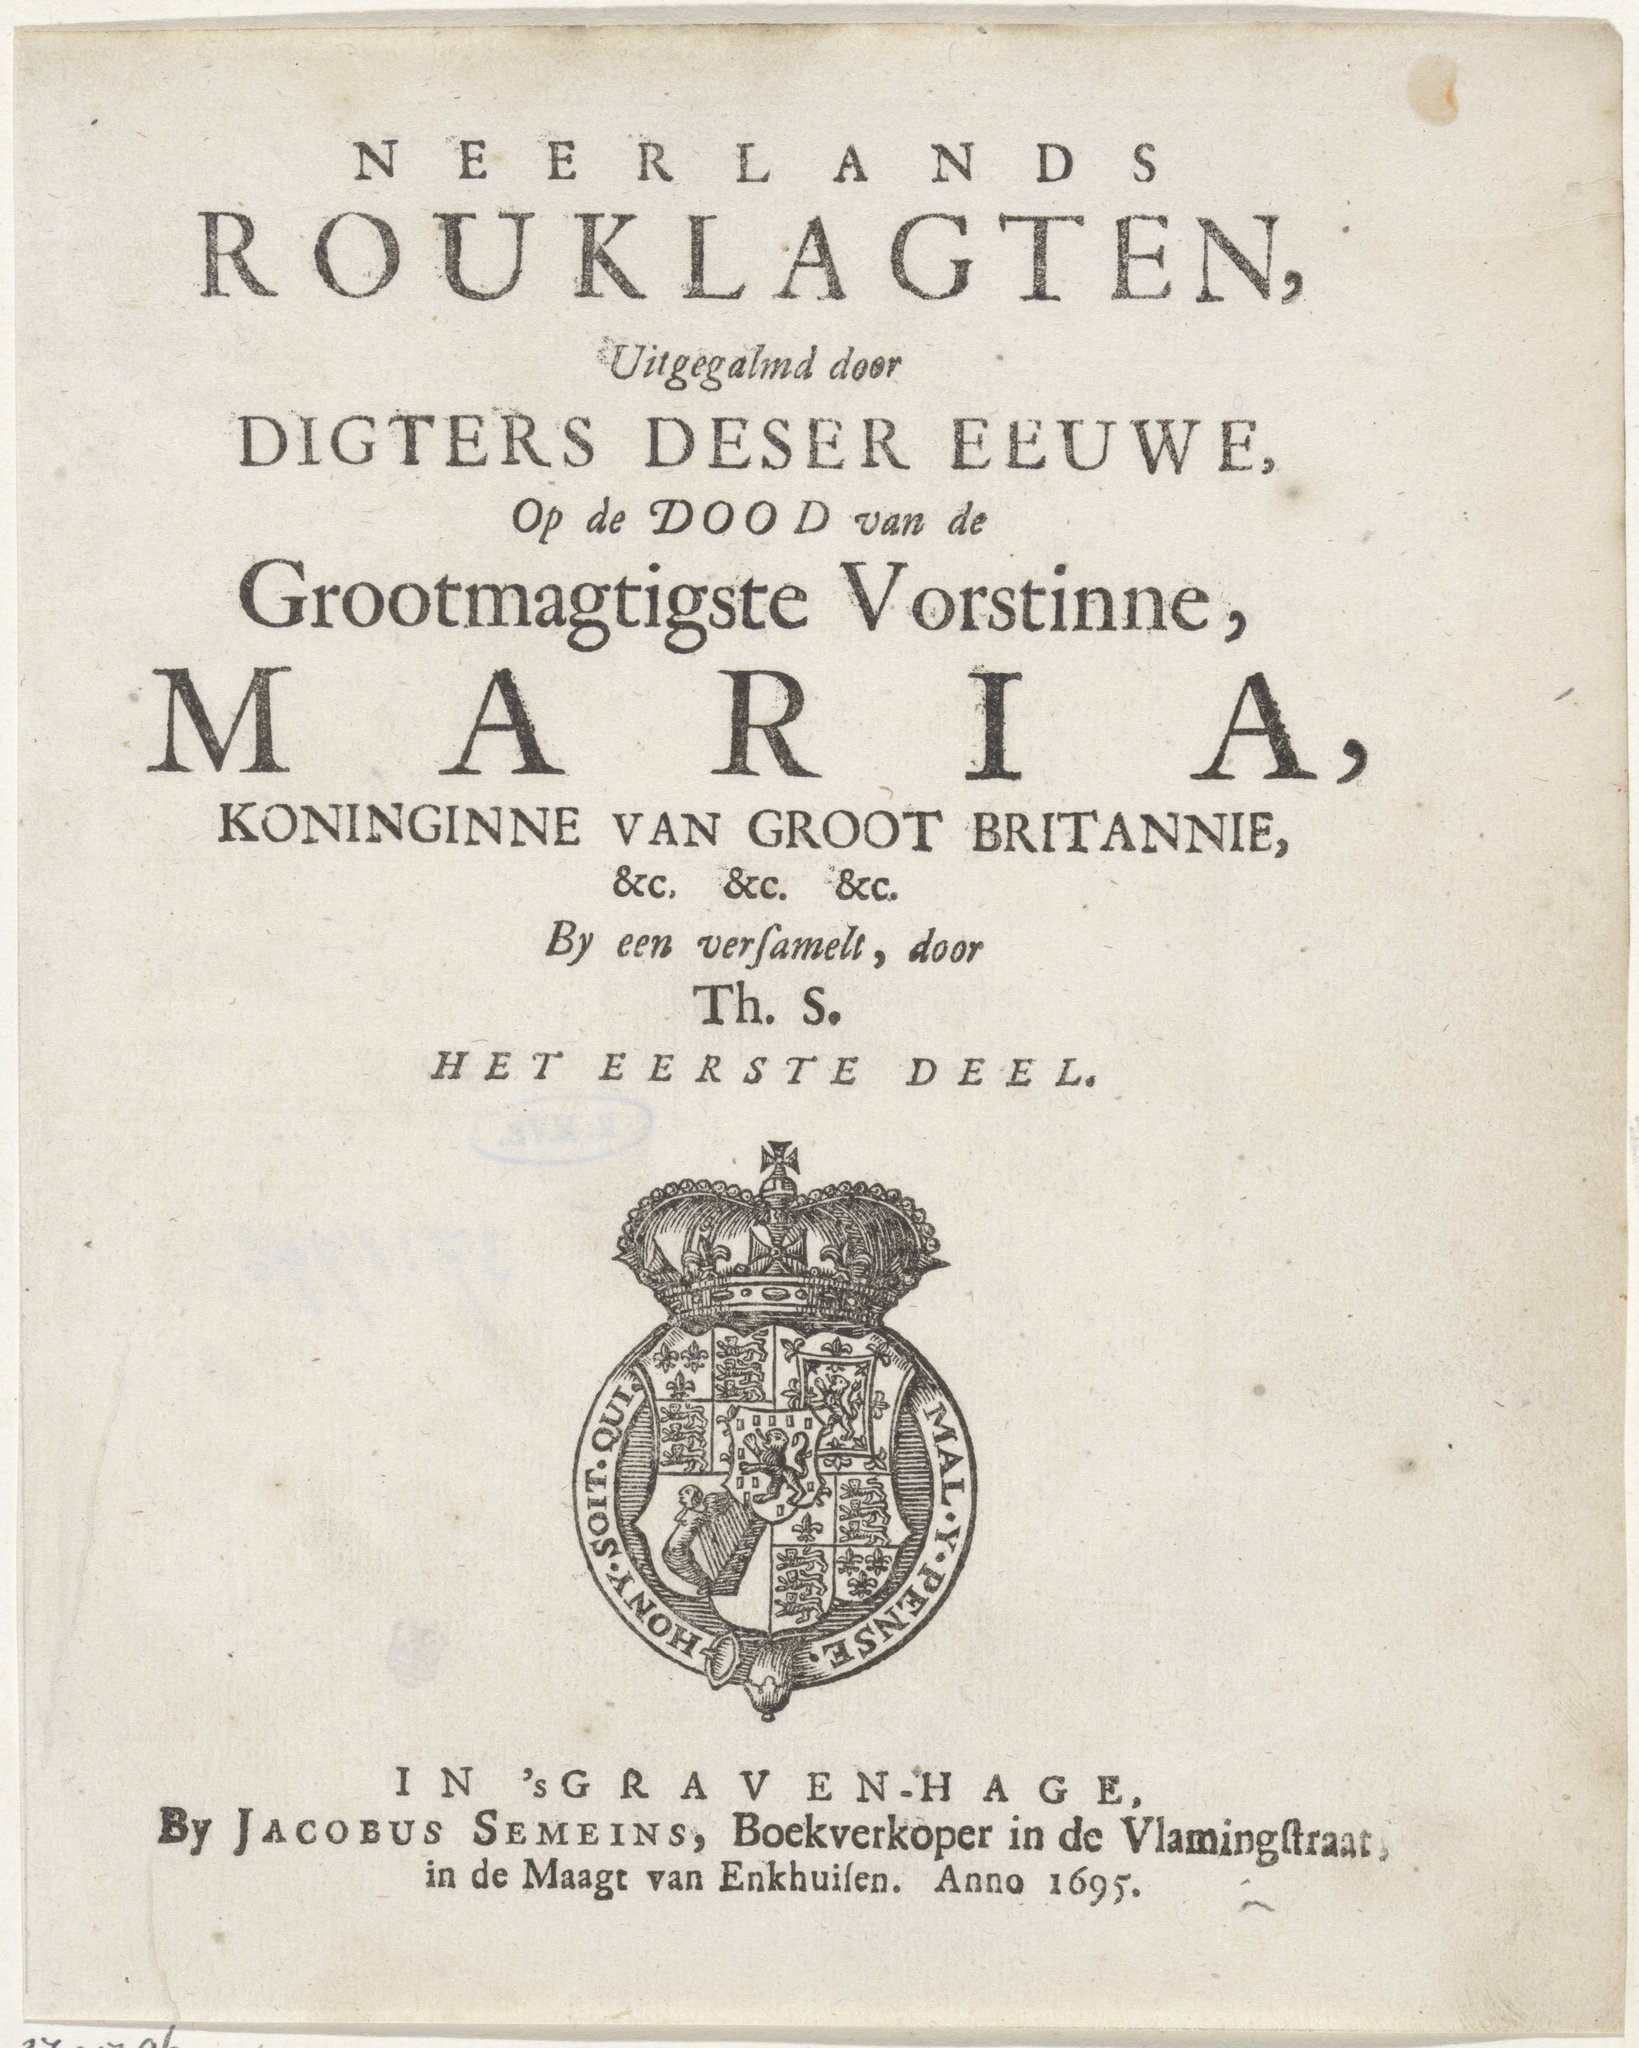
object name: titelblad, titelpagina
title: Wapen van het Verenigd Koninkrijk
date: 1695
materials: paper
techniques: etching, letterpress printing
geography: the hague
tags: orde van de kouseband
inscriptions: collector's mark: Lugt 2760, collector's mark: Lugt 2228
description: Titelpagina voor: Th[eodorus] S[choon] (samensteller). Neerlands rouklagten, uitgegalmd door digters deser eeuwe, op de dood van (...) Maria, koninginne van Groot Britannie. Den Haag: Jacobus Semeins, 1695.